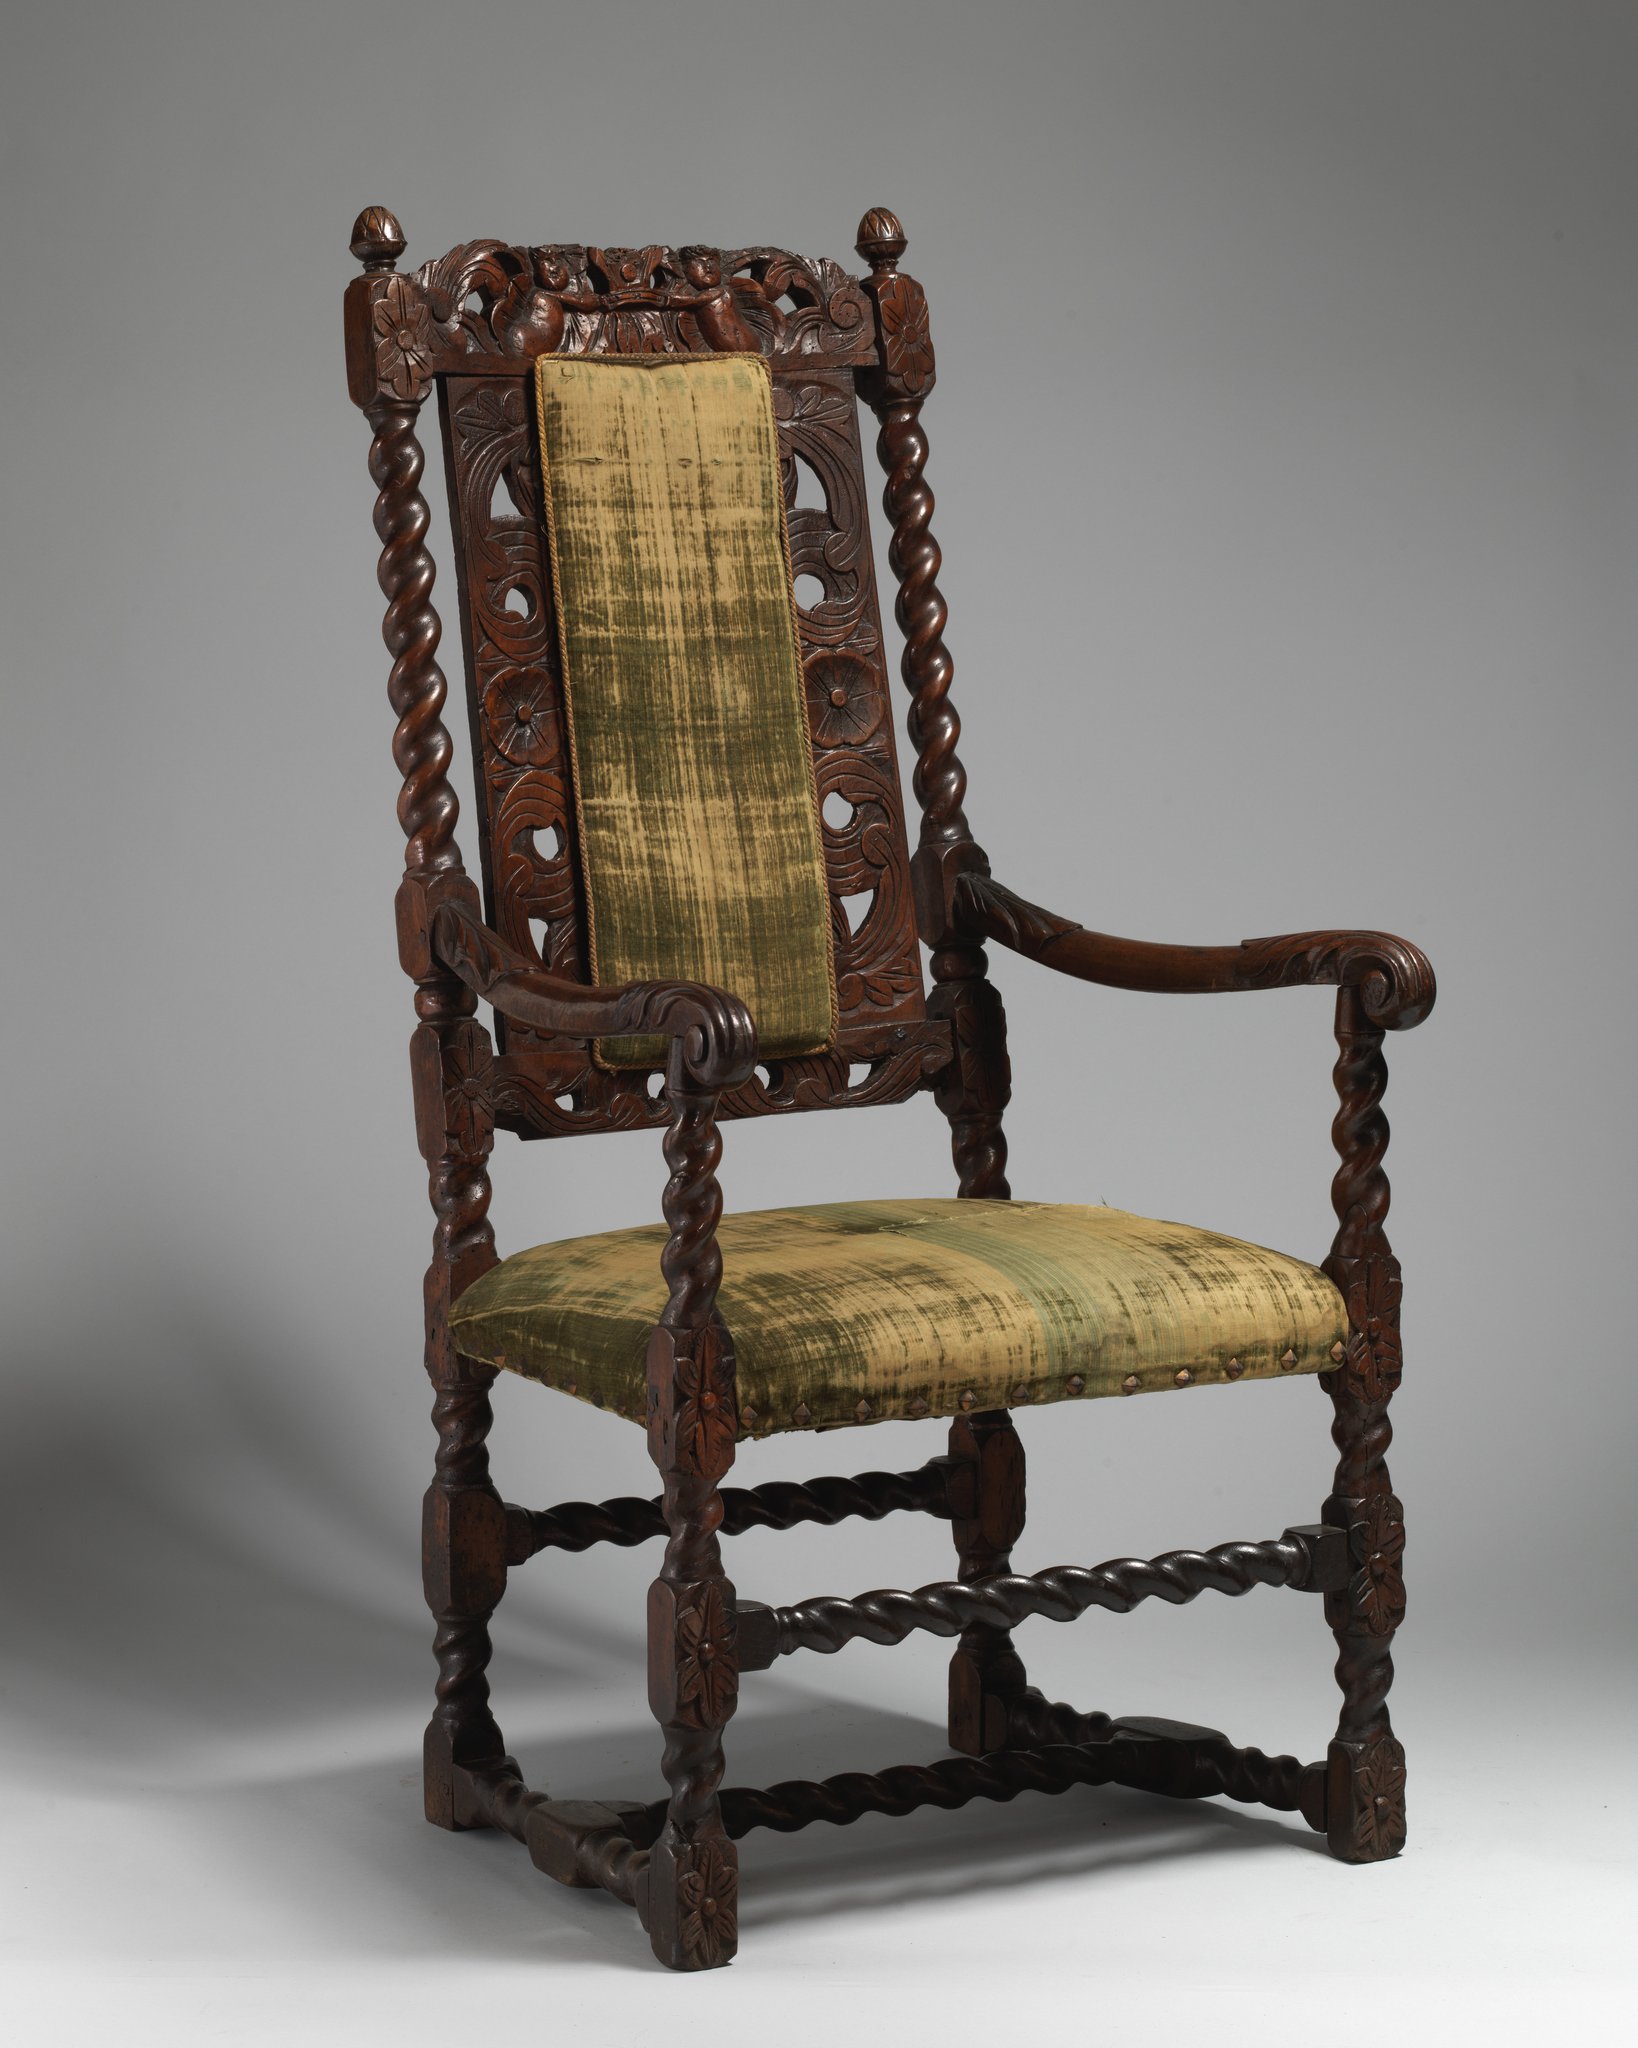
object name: armchair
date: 1660-1685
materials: wood